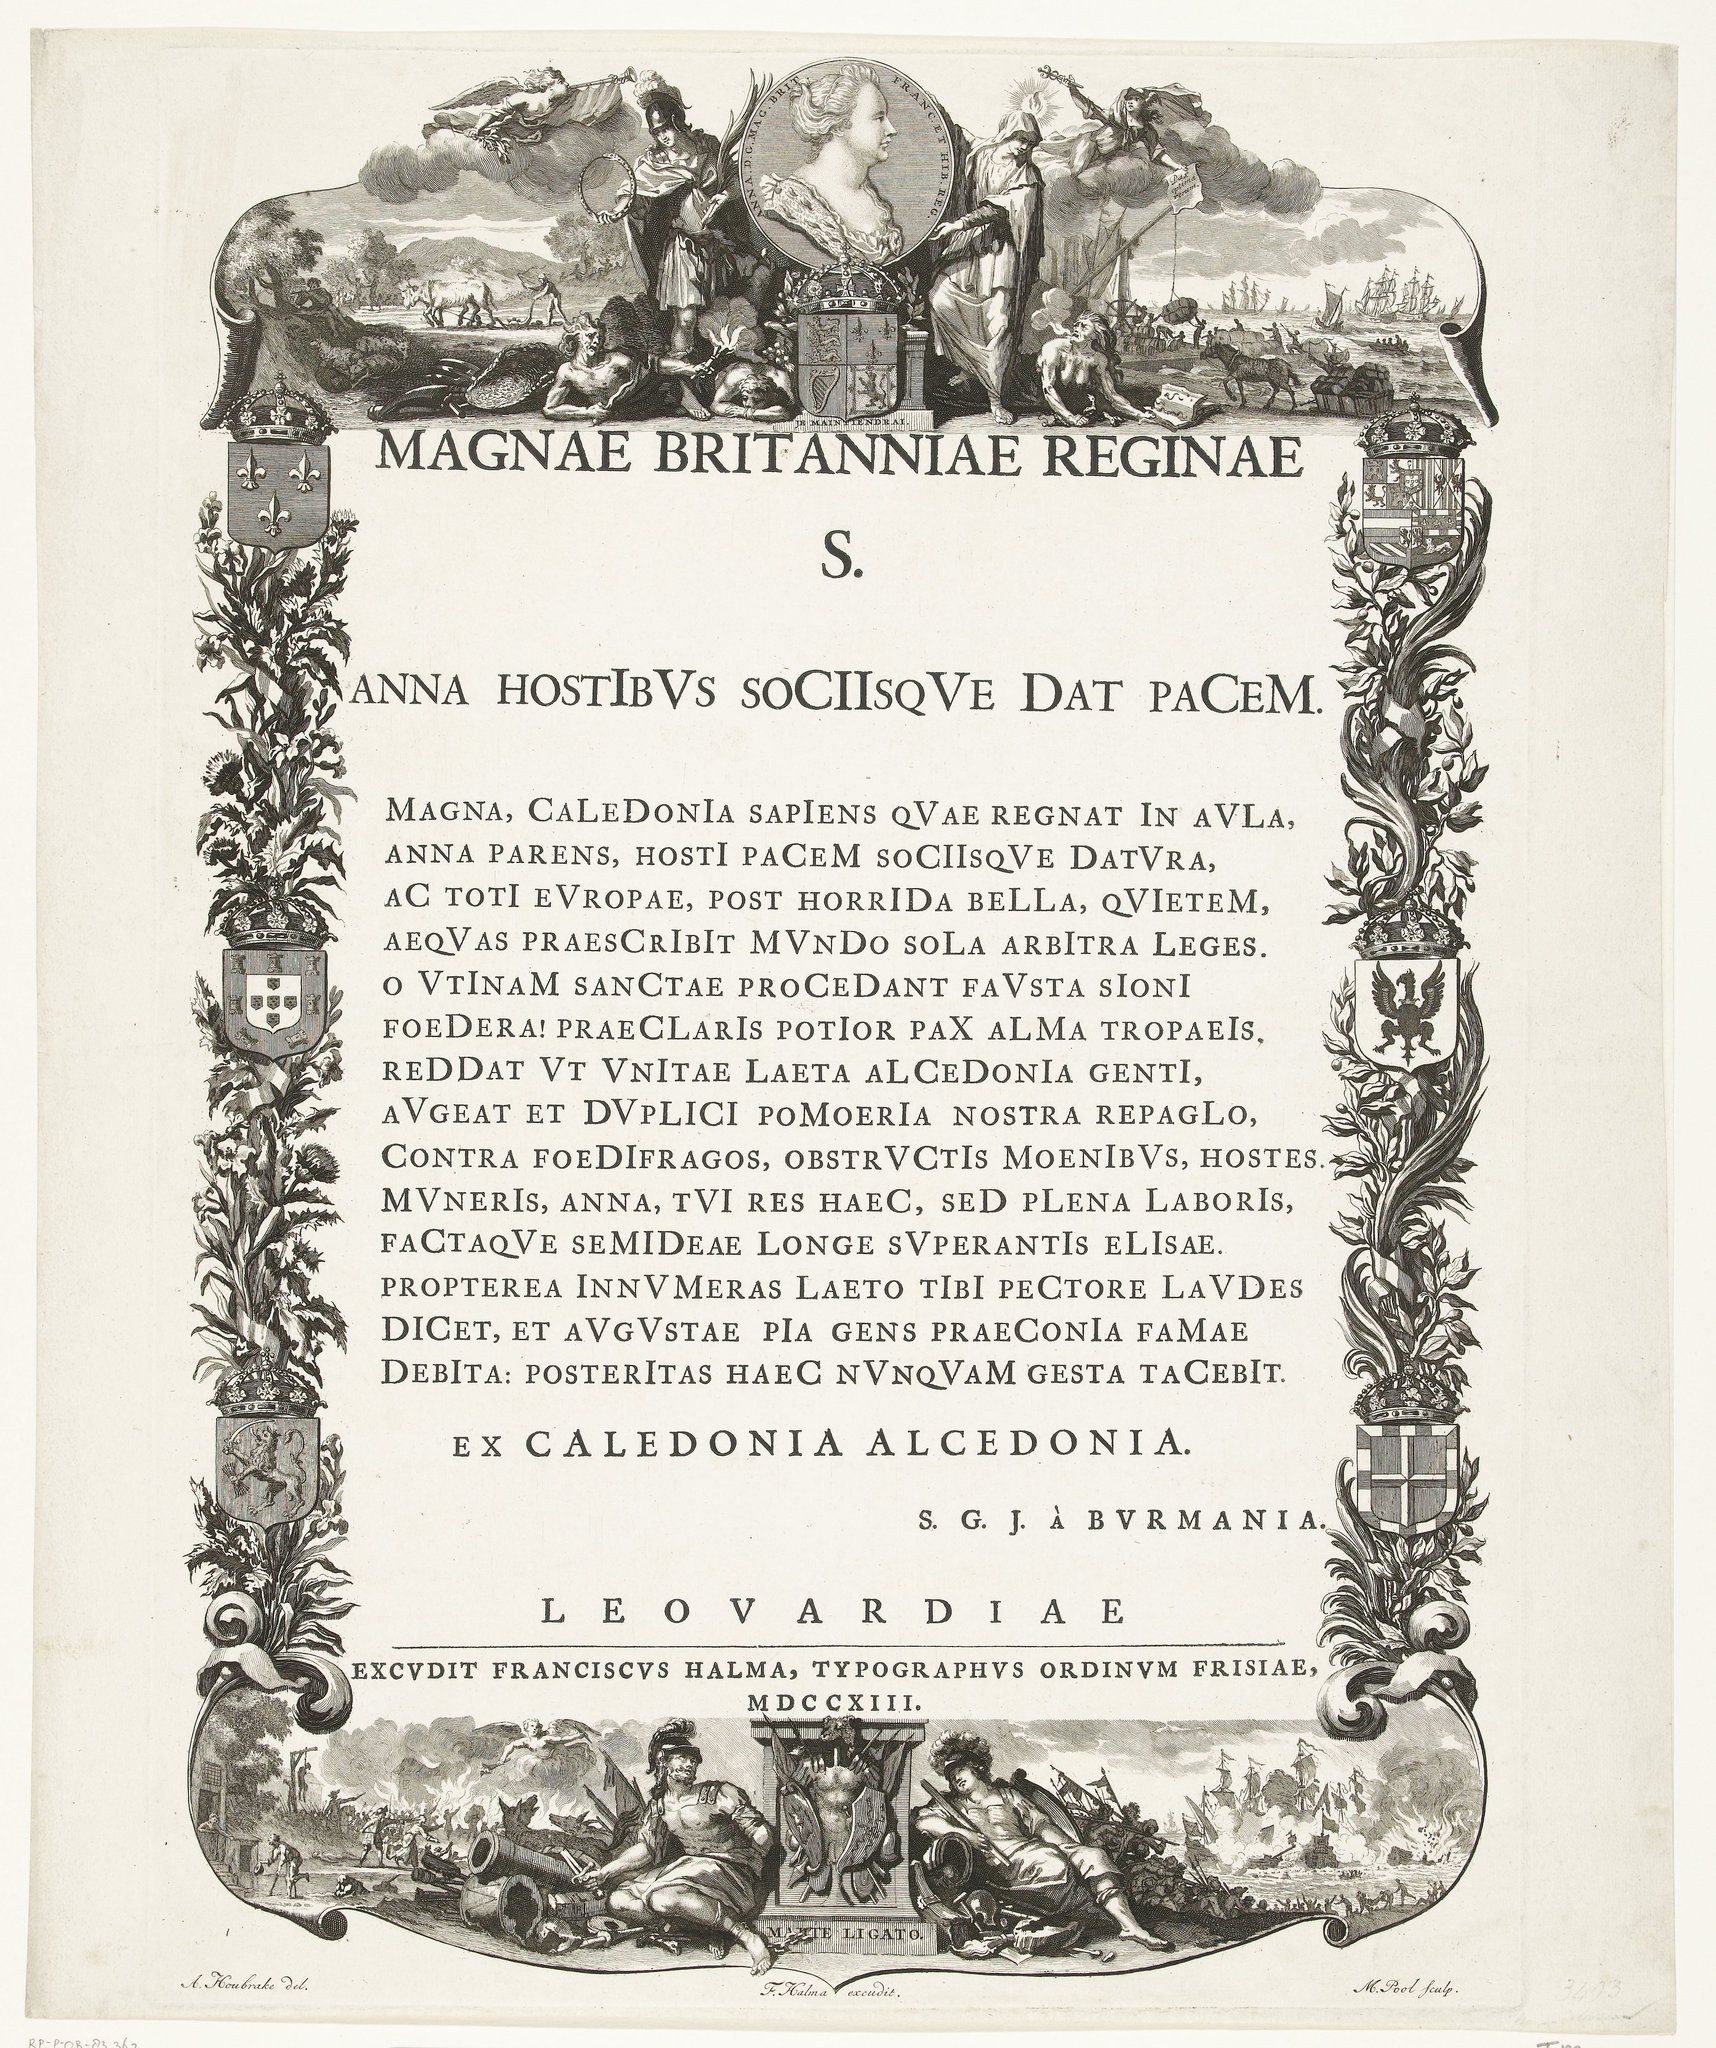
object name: print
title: Magnae Britanniae Reginae S. Anna Hostibus Sociisque Dat Pacem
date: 1713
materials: paper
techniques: etching, letterpress printing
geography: friesland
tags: london, anna stuart (koningin van engeland en schotland), consequences of peace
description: Allegorie ter ere van koningin Anna en haar rol in het bereiken van de Vrede van Utrecht, 1713. Centraal een vers in het Latijn waarvan elke regel een tijdvers of chronogram van het jaar 1713 is. In het randwerk bovenaan een portret van koningin Anna bij scènes van het herstel van de landbouw en de handel dankzij de vrede. Aan de zijden de wapens van de partijen in de oorlog. Onderaan zitten Mars en Bellona geboeid en verslagen.